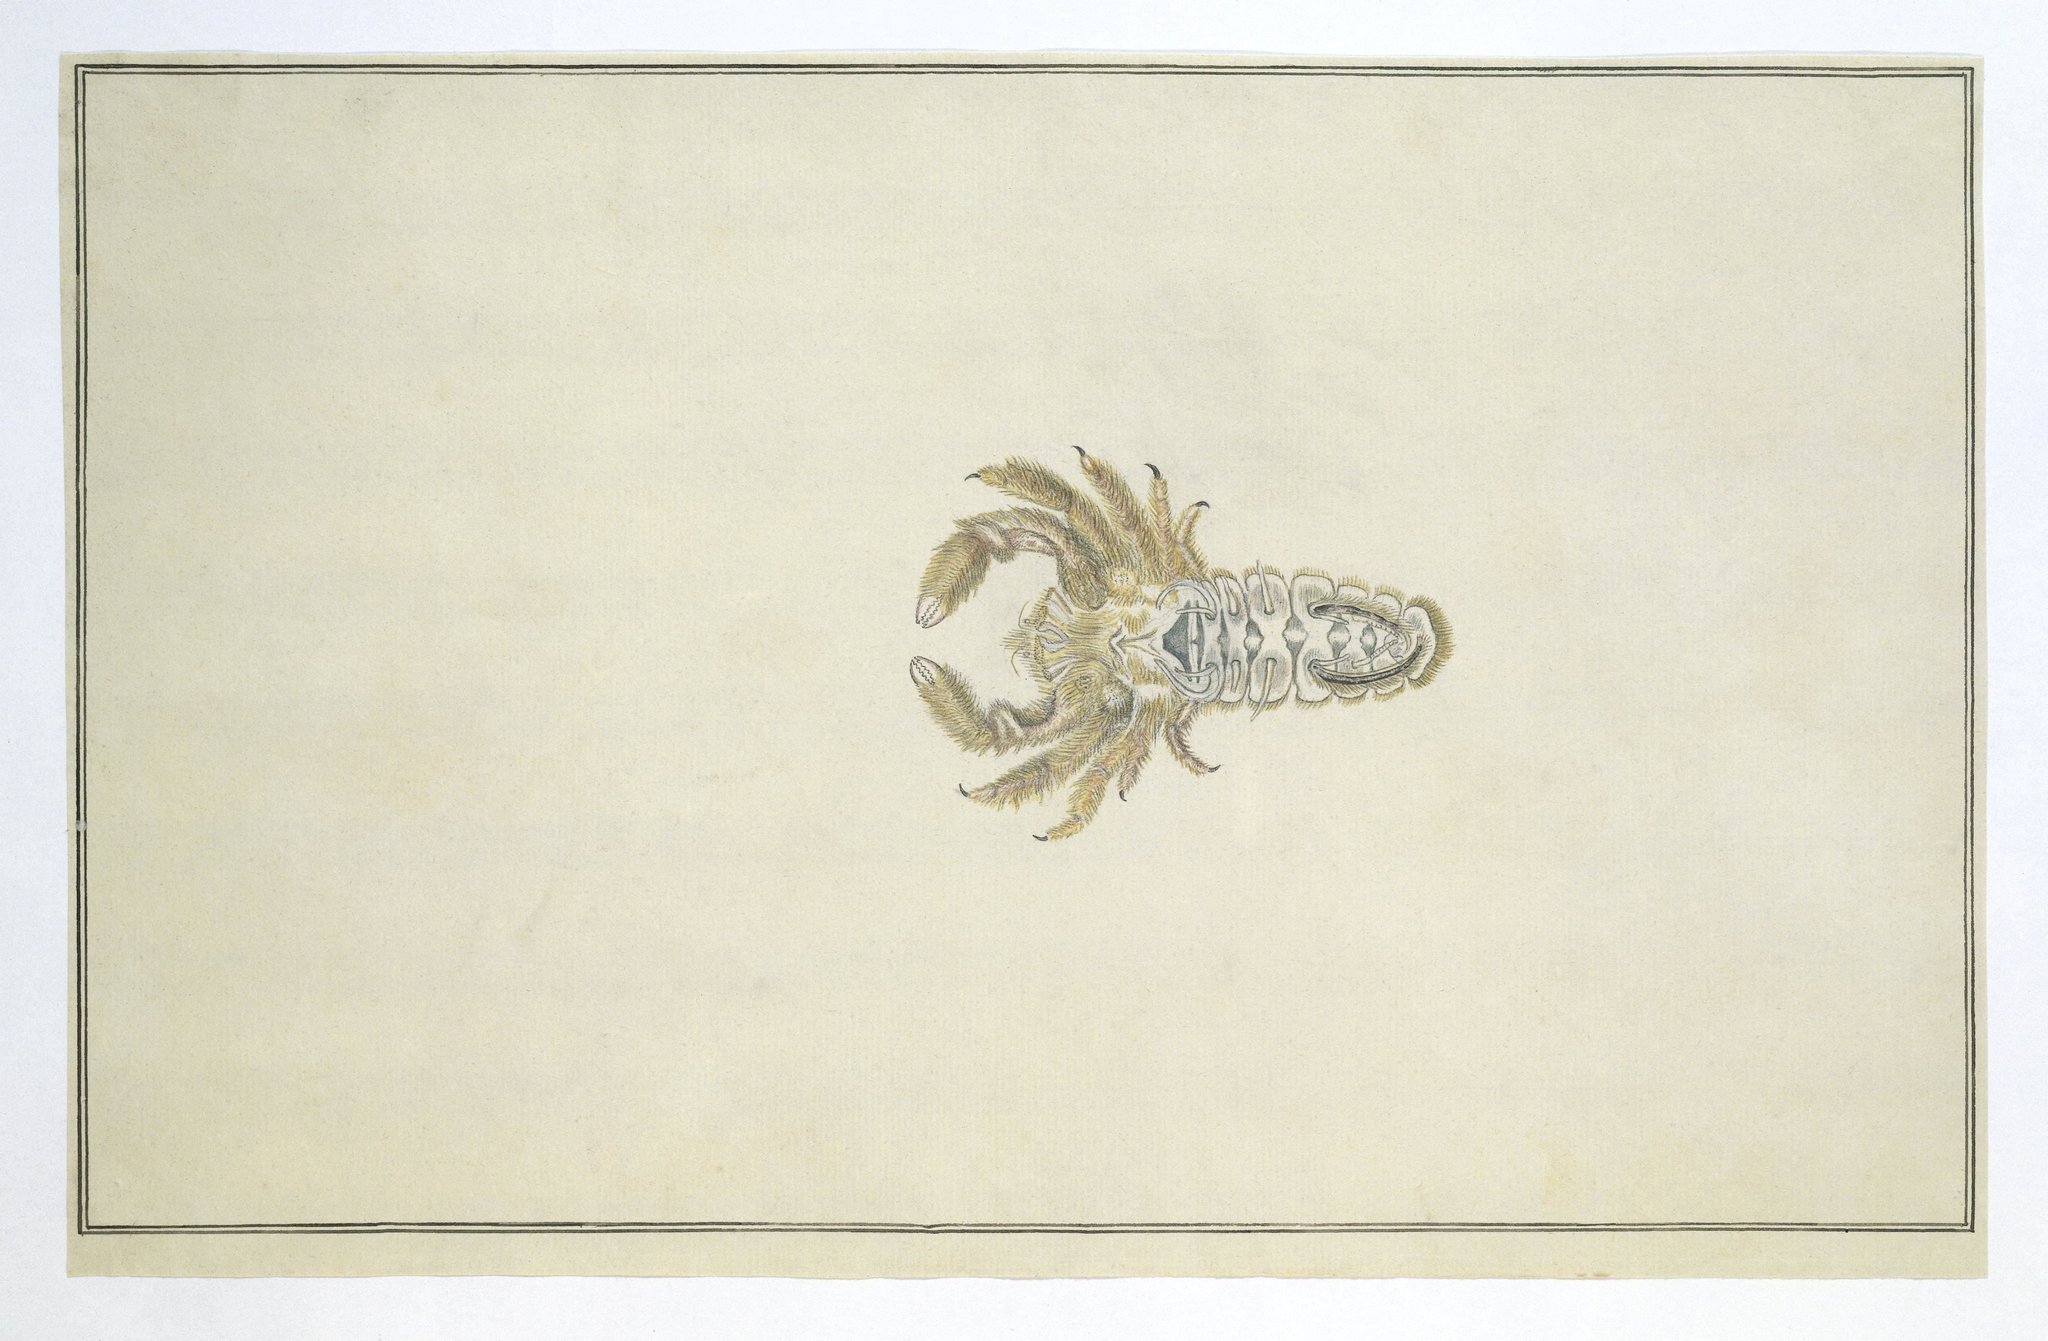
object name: drawing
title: Crab (probably of the Potamon genus)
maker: robert jacob gordon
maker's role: draughtsman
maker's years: 1743-1795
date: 1777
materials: chalk, ink, paper, pencil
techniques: brush, pen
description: Ongeïdentificeerd, waarschijnlijk van de Potamon genus.